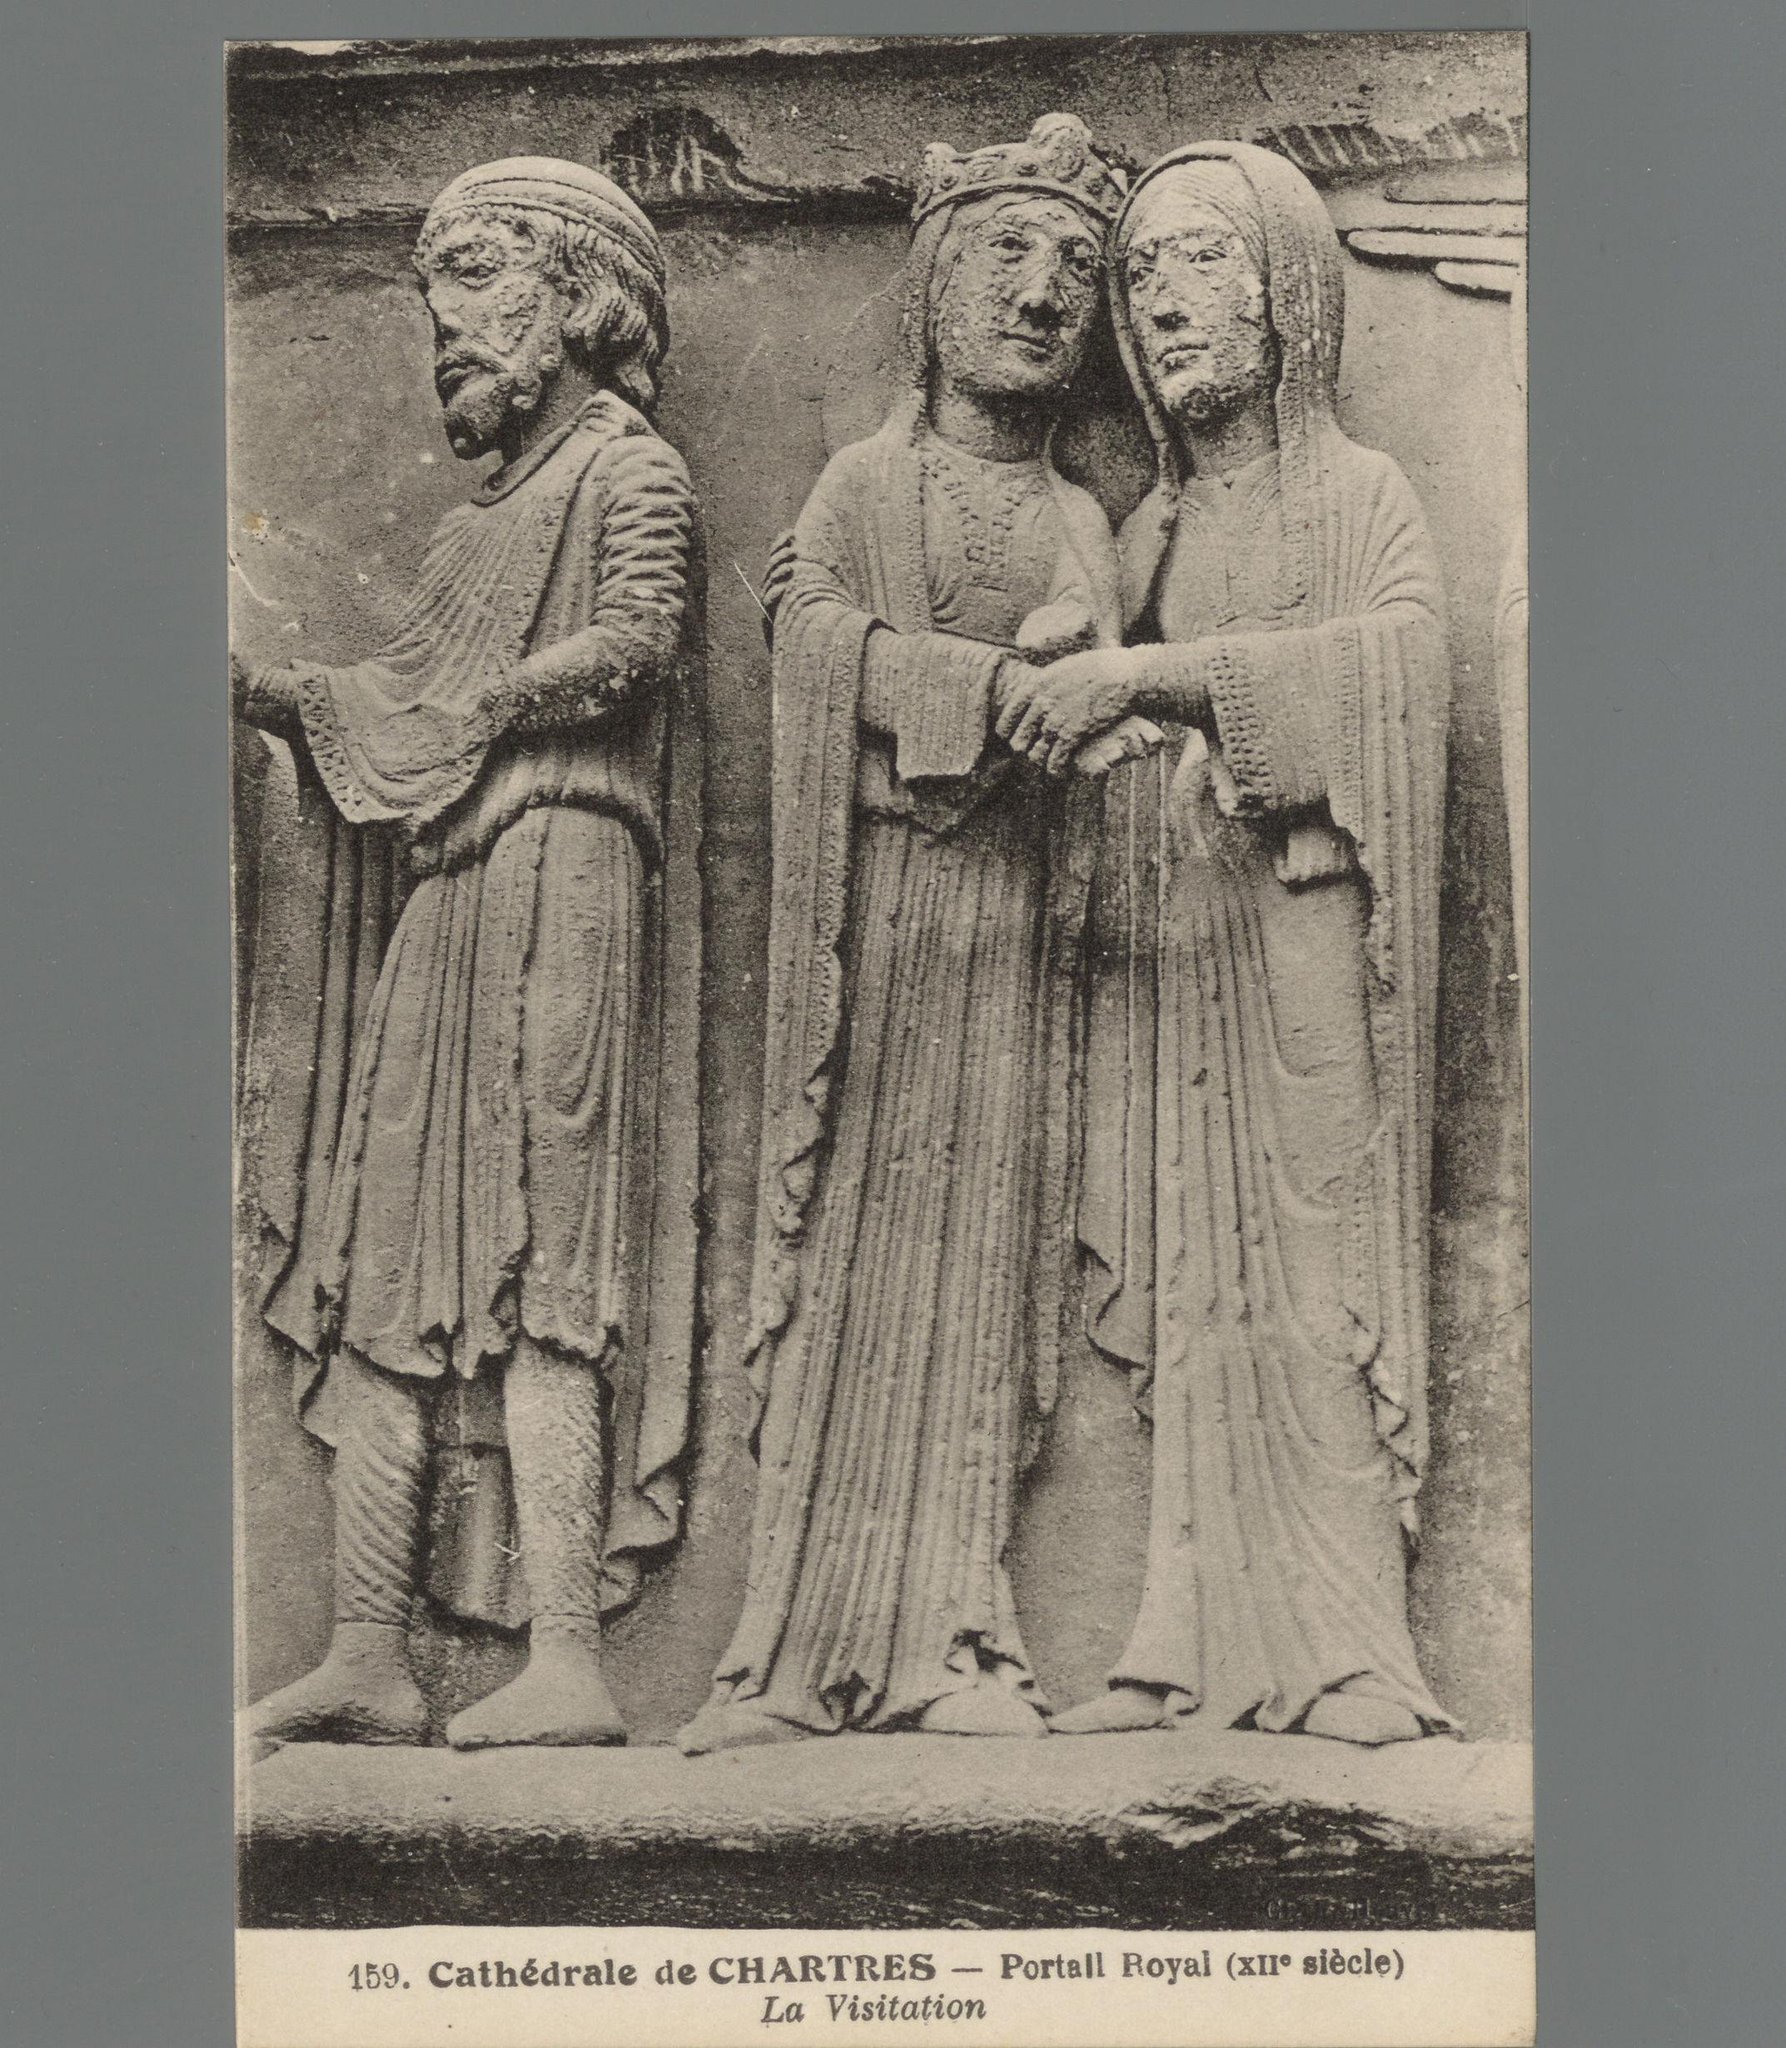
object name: ansichtkaart, prentbriefkaart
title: Cathédrale de Chartres - Portail Royal (XIIe siècle). La Visitation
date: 1903-1930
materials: cardboard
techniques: photograph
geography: chartres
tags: church (exterior), statues, paintings, etc. ~ objects of worship in roman religion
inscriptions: collector's mark: ‘AFE v S’